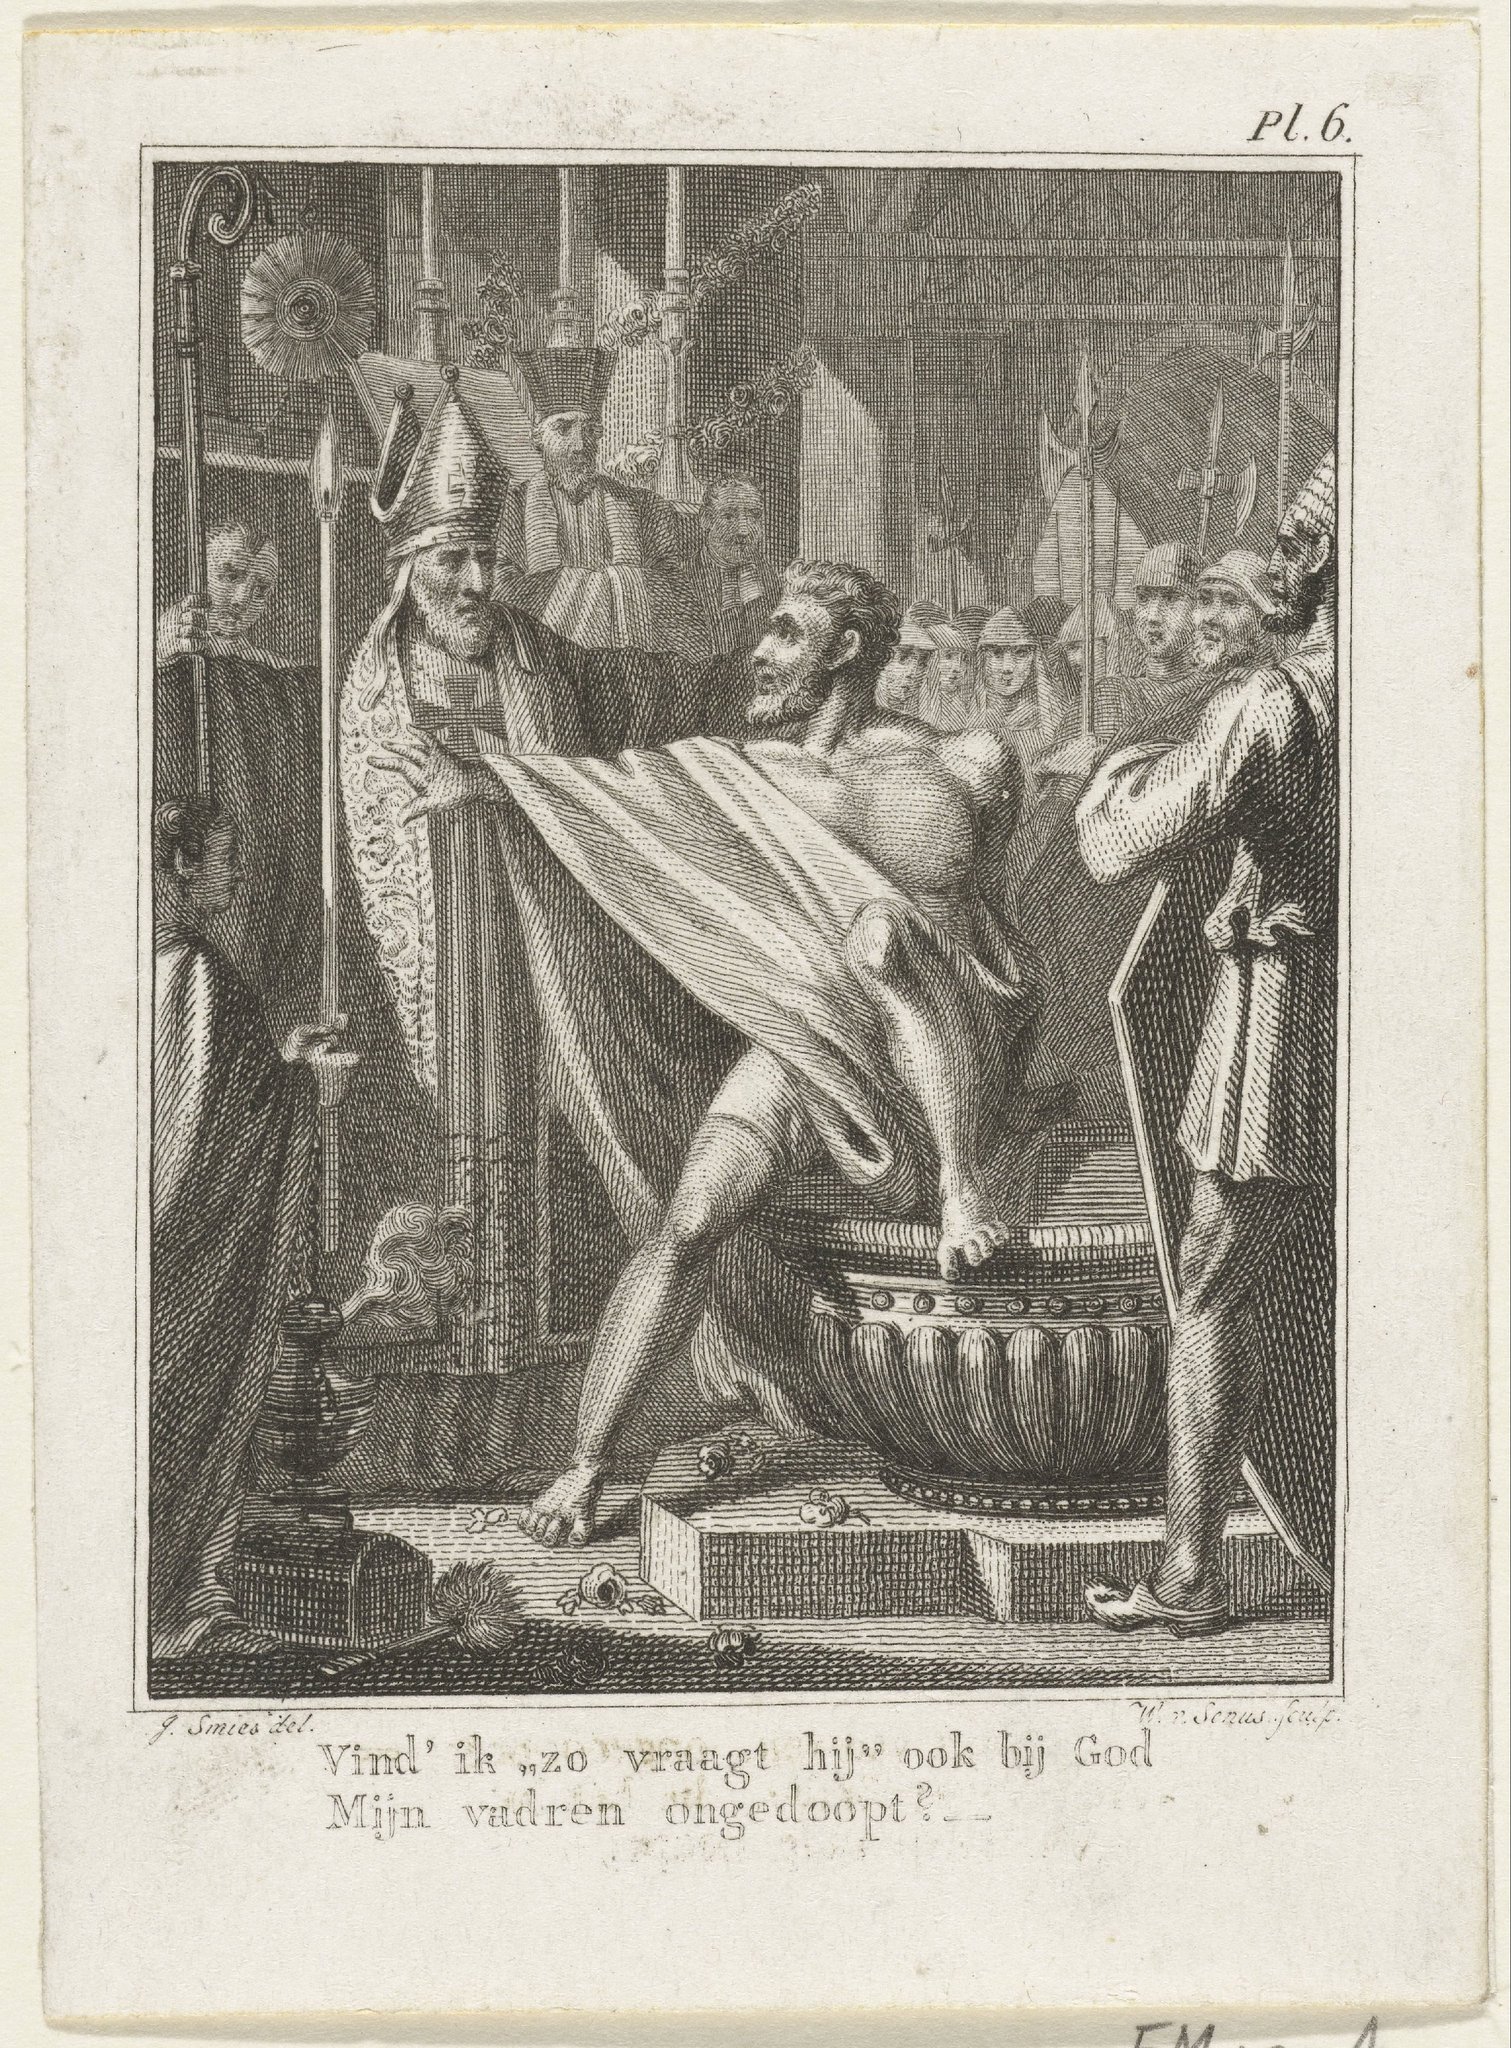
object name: print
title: Radbod laat zich niet dopen, 719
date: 1775-1835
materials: paper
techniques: etching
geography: netherlands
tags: solemn baptism (by bishop or priest), netherlands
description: Radbod, koning der Friezen, weigert zich in 719 door bisschop Wulfram van Sens te laten dopen. Radbod staat met één been in de rand van het doopvont. Onder de voorstelling het onderschrift: Vind' ik "zo vraagt hij" ook bij God Mijn vadren ongedoopt?